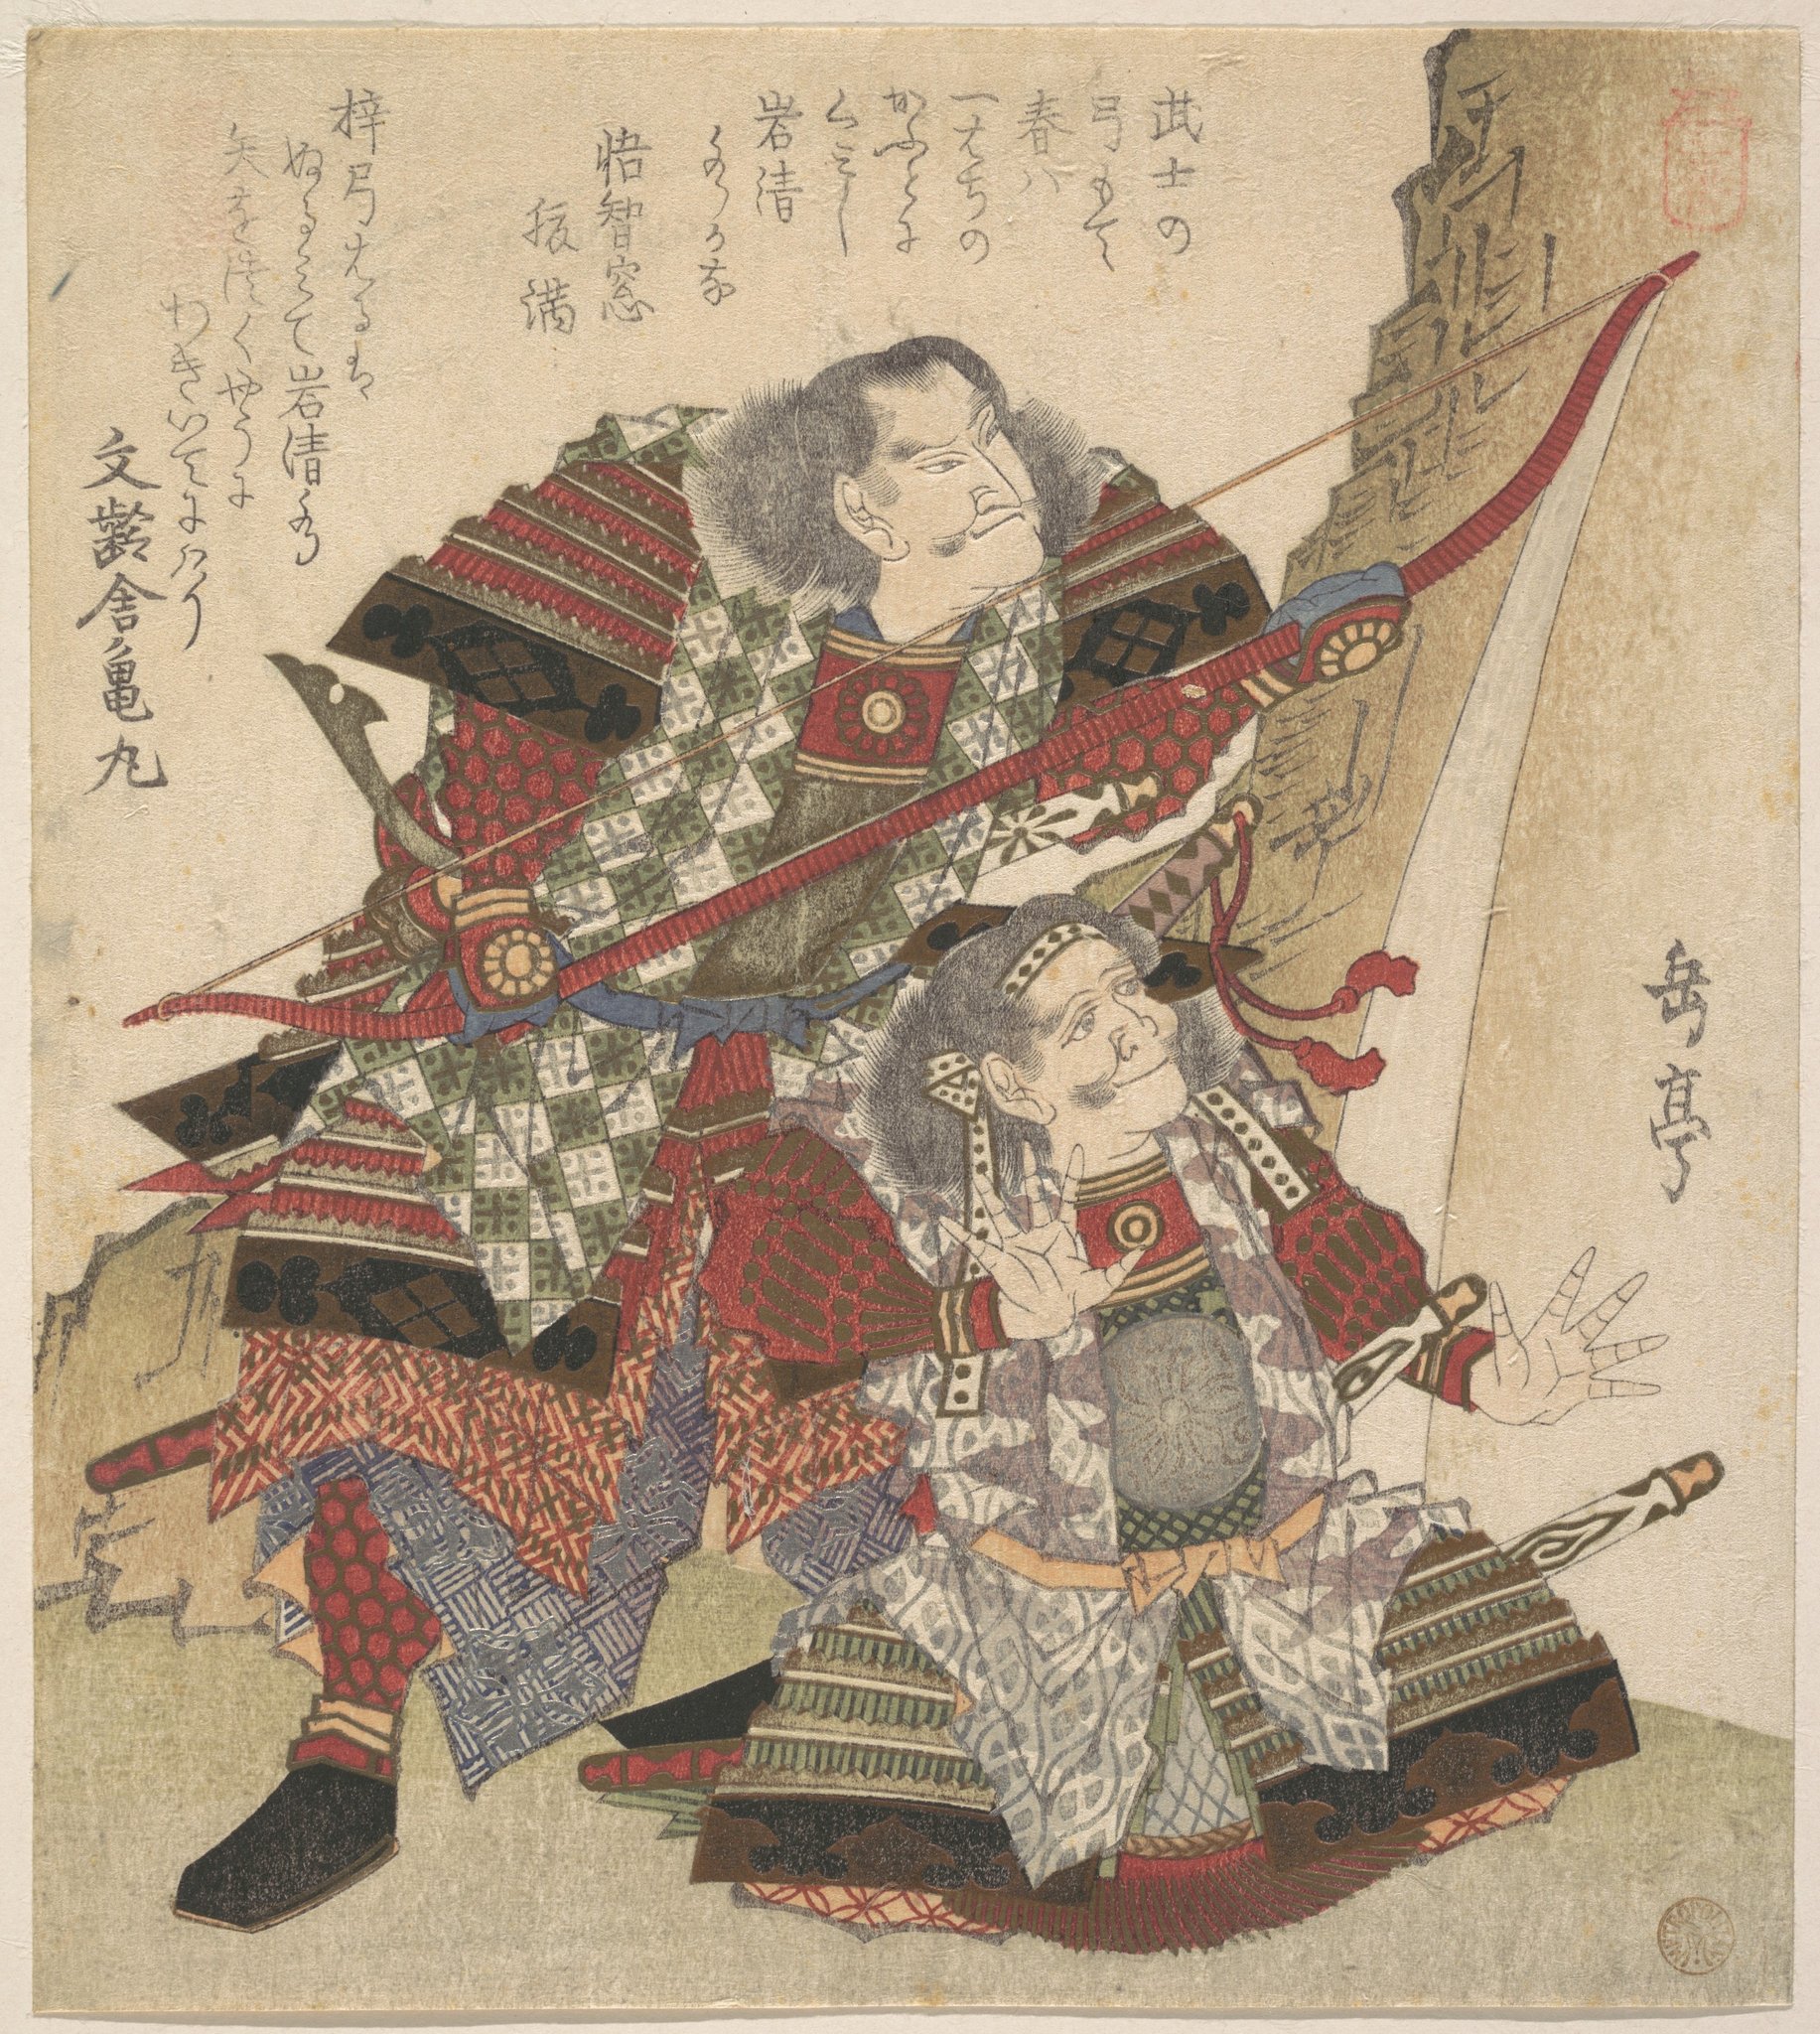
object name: print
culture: japanese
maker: yashima gakutei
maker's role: artist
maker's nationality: japanese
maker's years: 1786-1868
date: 1830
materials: ink, paper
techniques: surimono, woodblock print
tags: bow and arrow,men